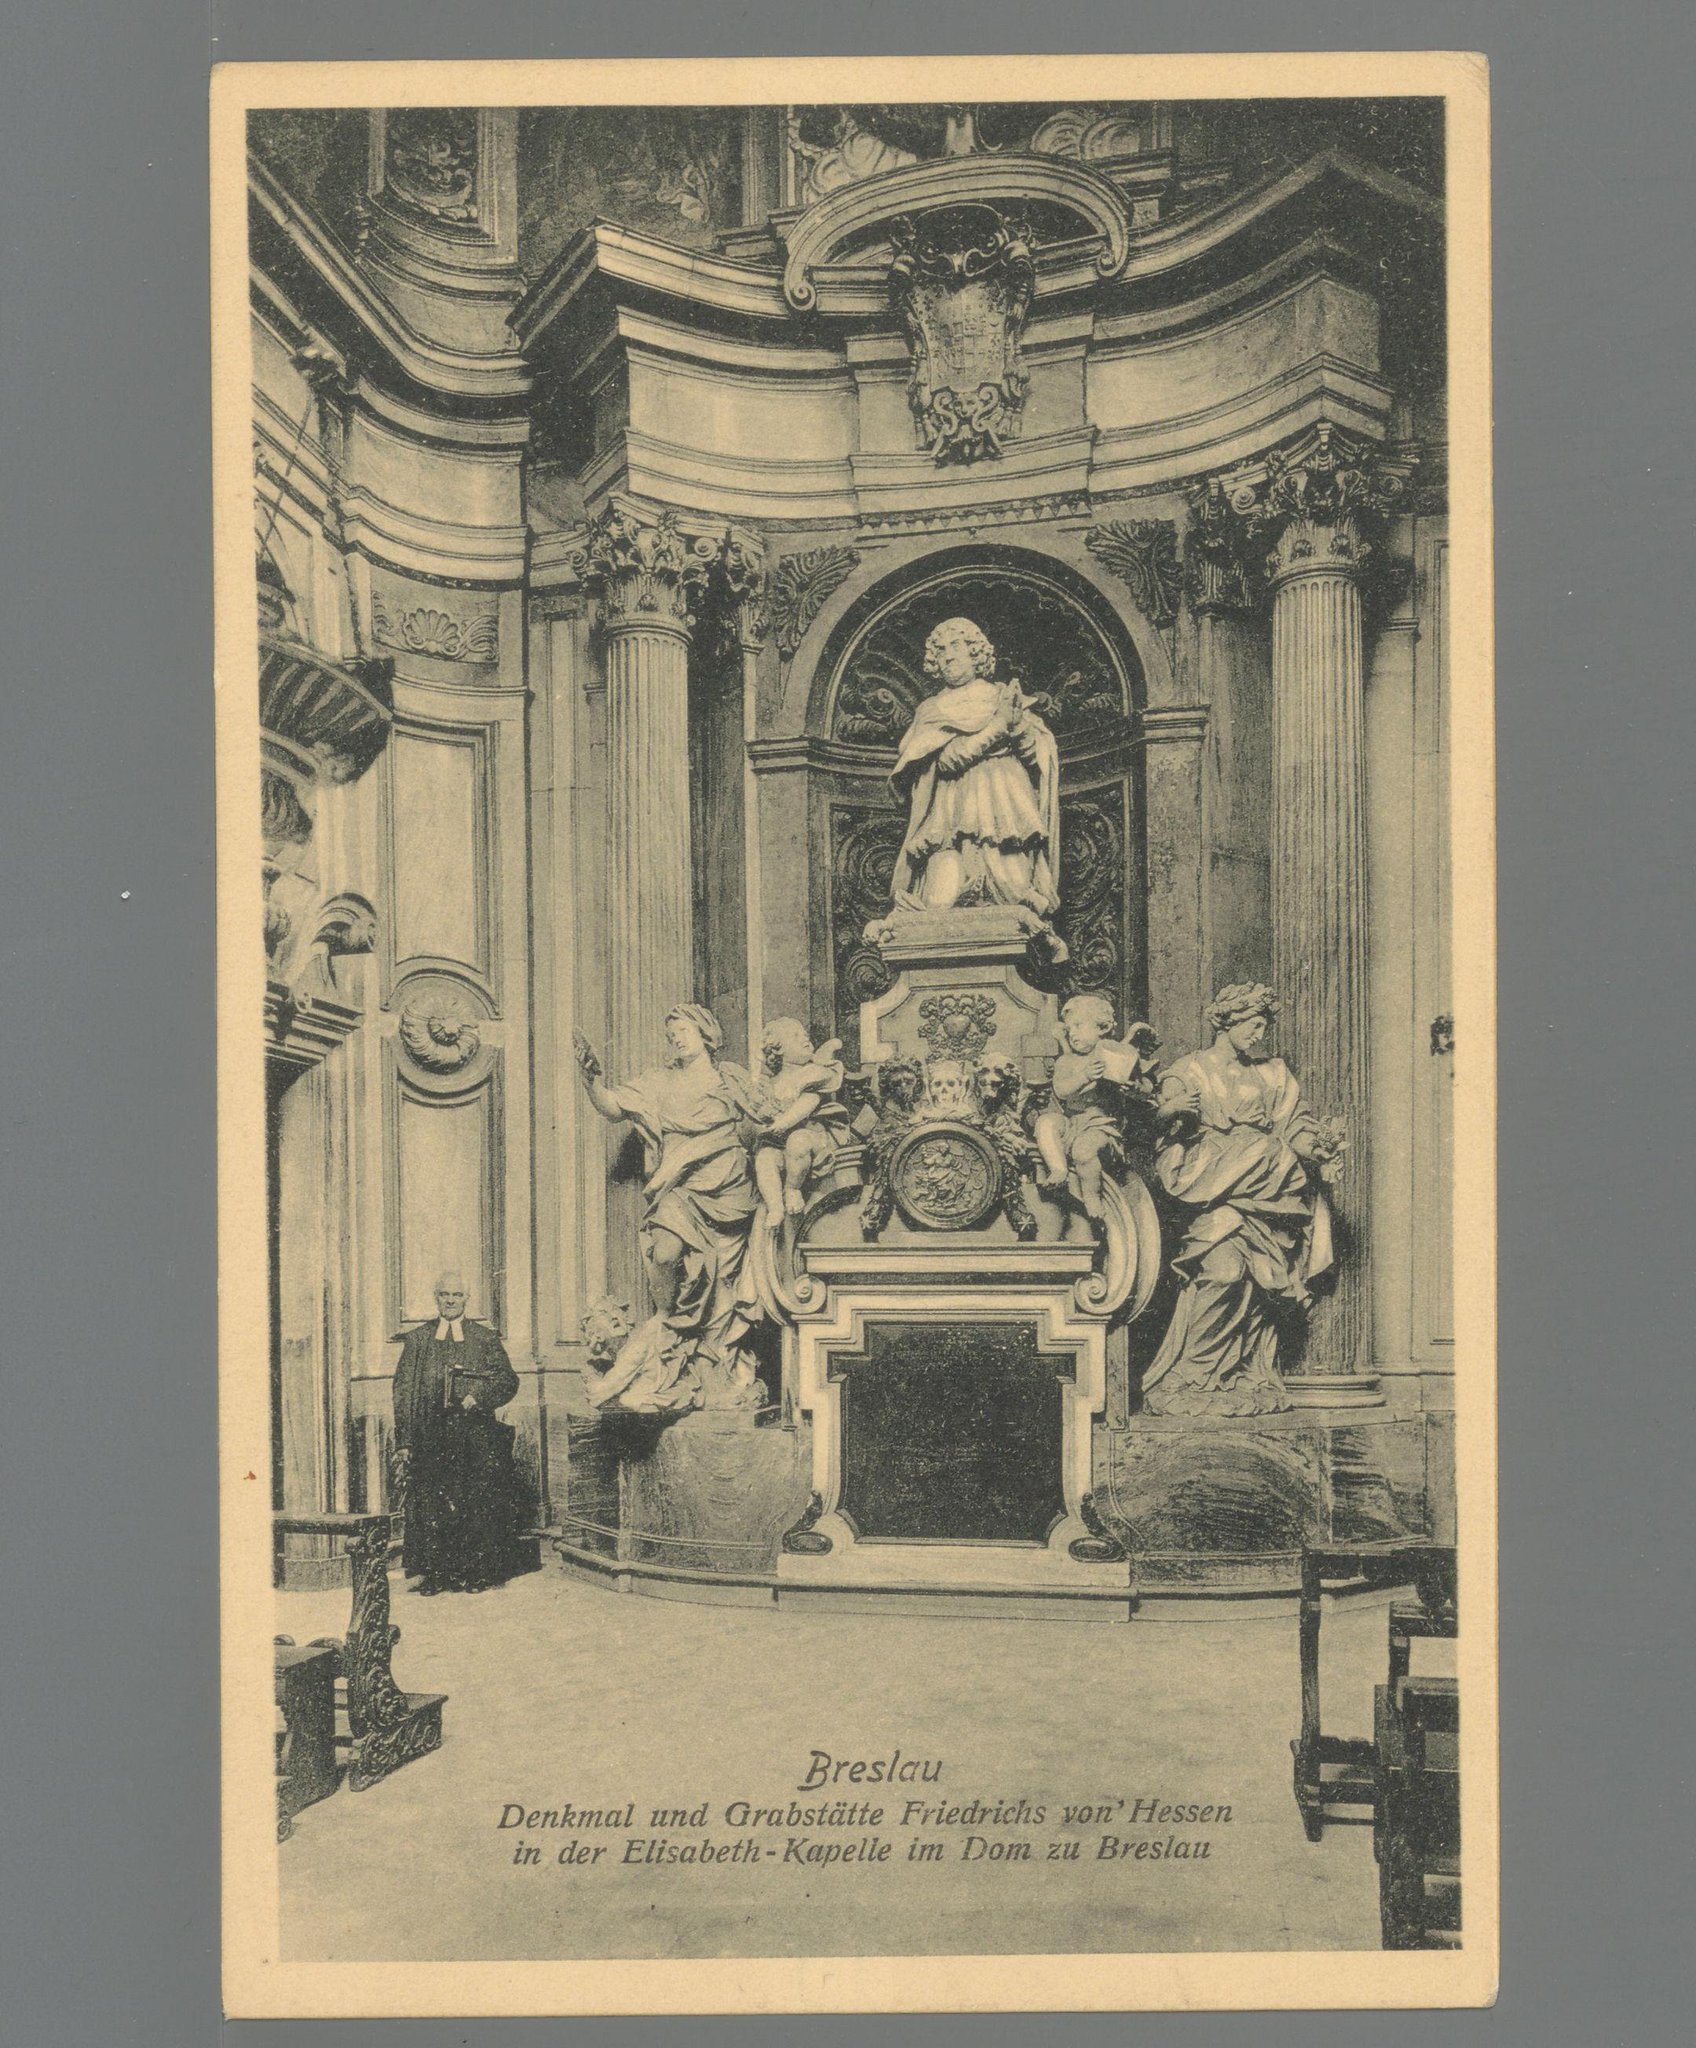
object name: photomechanical print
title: Breslau. Denkmal und Grabstätte Friedrichs von'Hessen in der Elisabeth-Kapelle im Dom zu Breslau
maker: Anonymous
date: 1908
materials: cardboard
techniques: photograph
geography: leipzig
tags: grave, tomb, interior of church, monument, statue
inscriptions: date